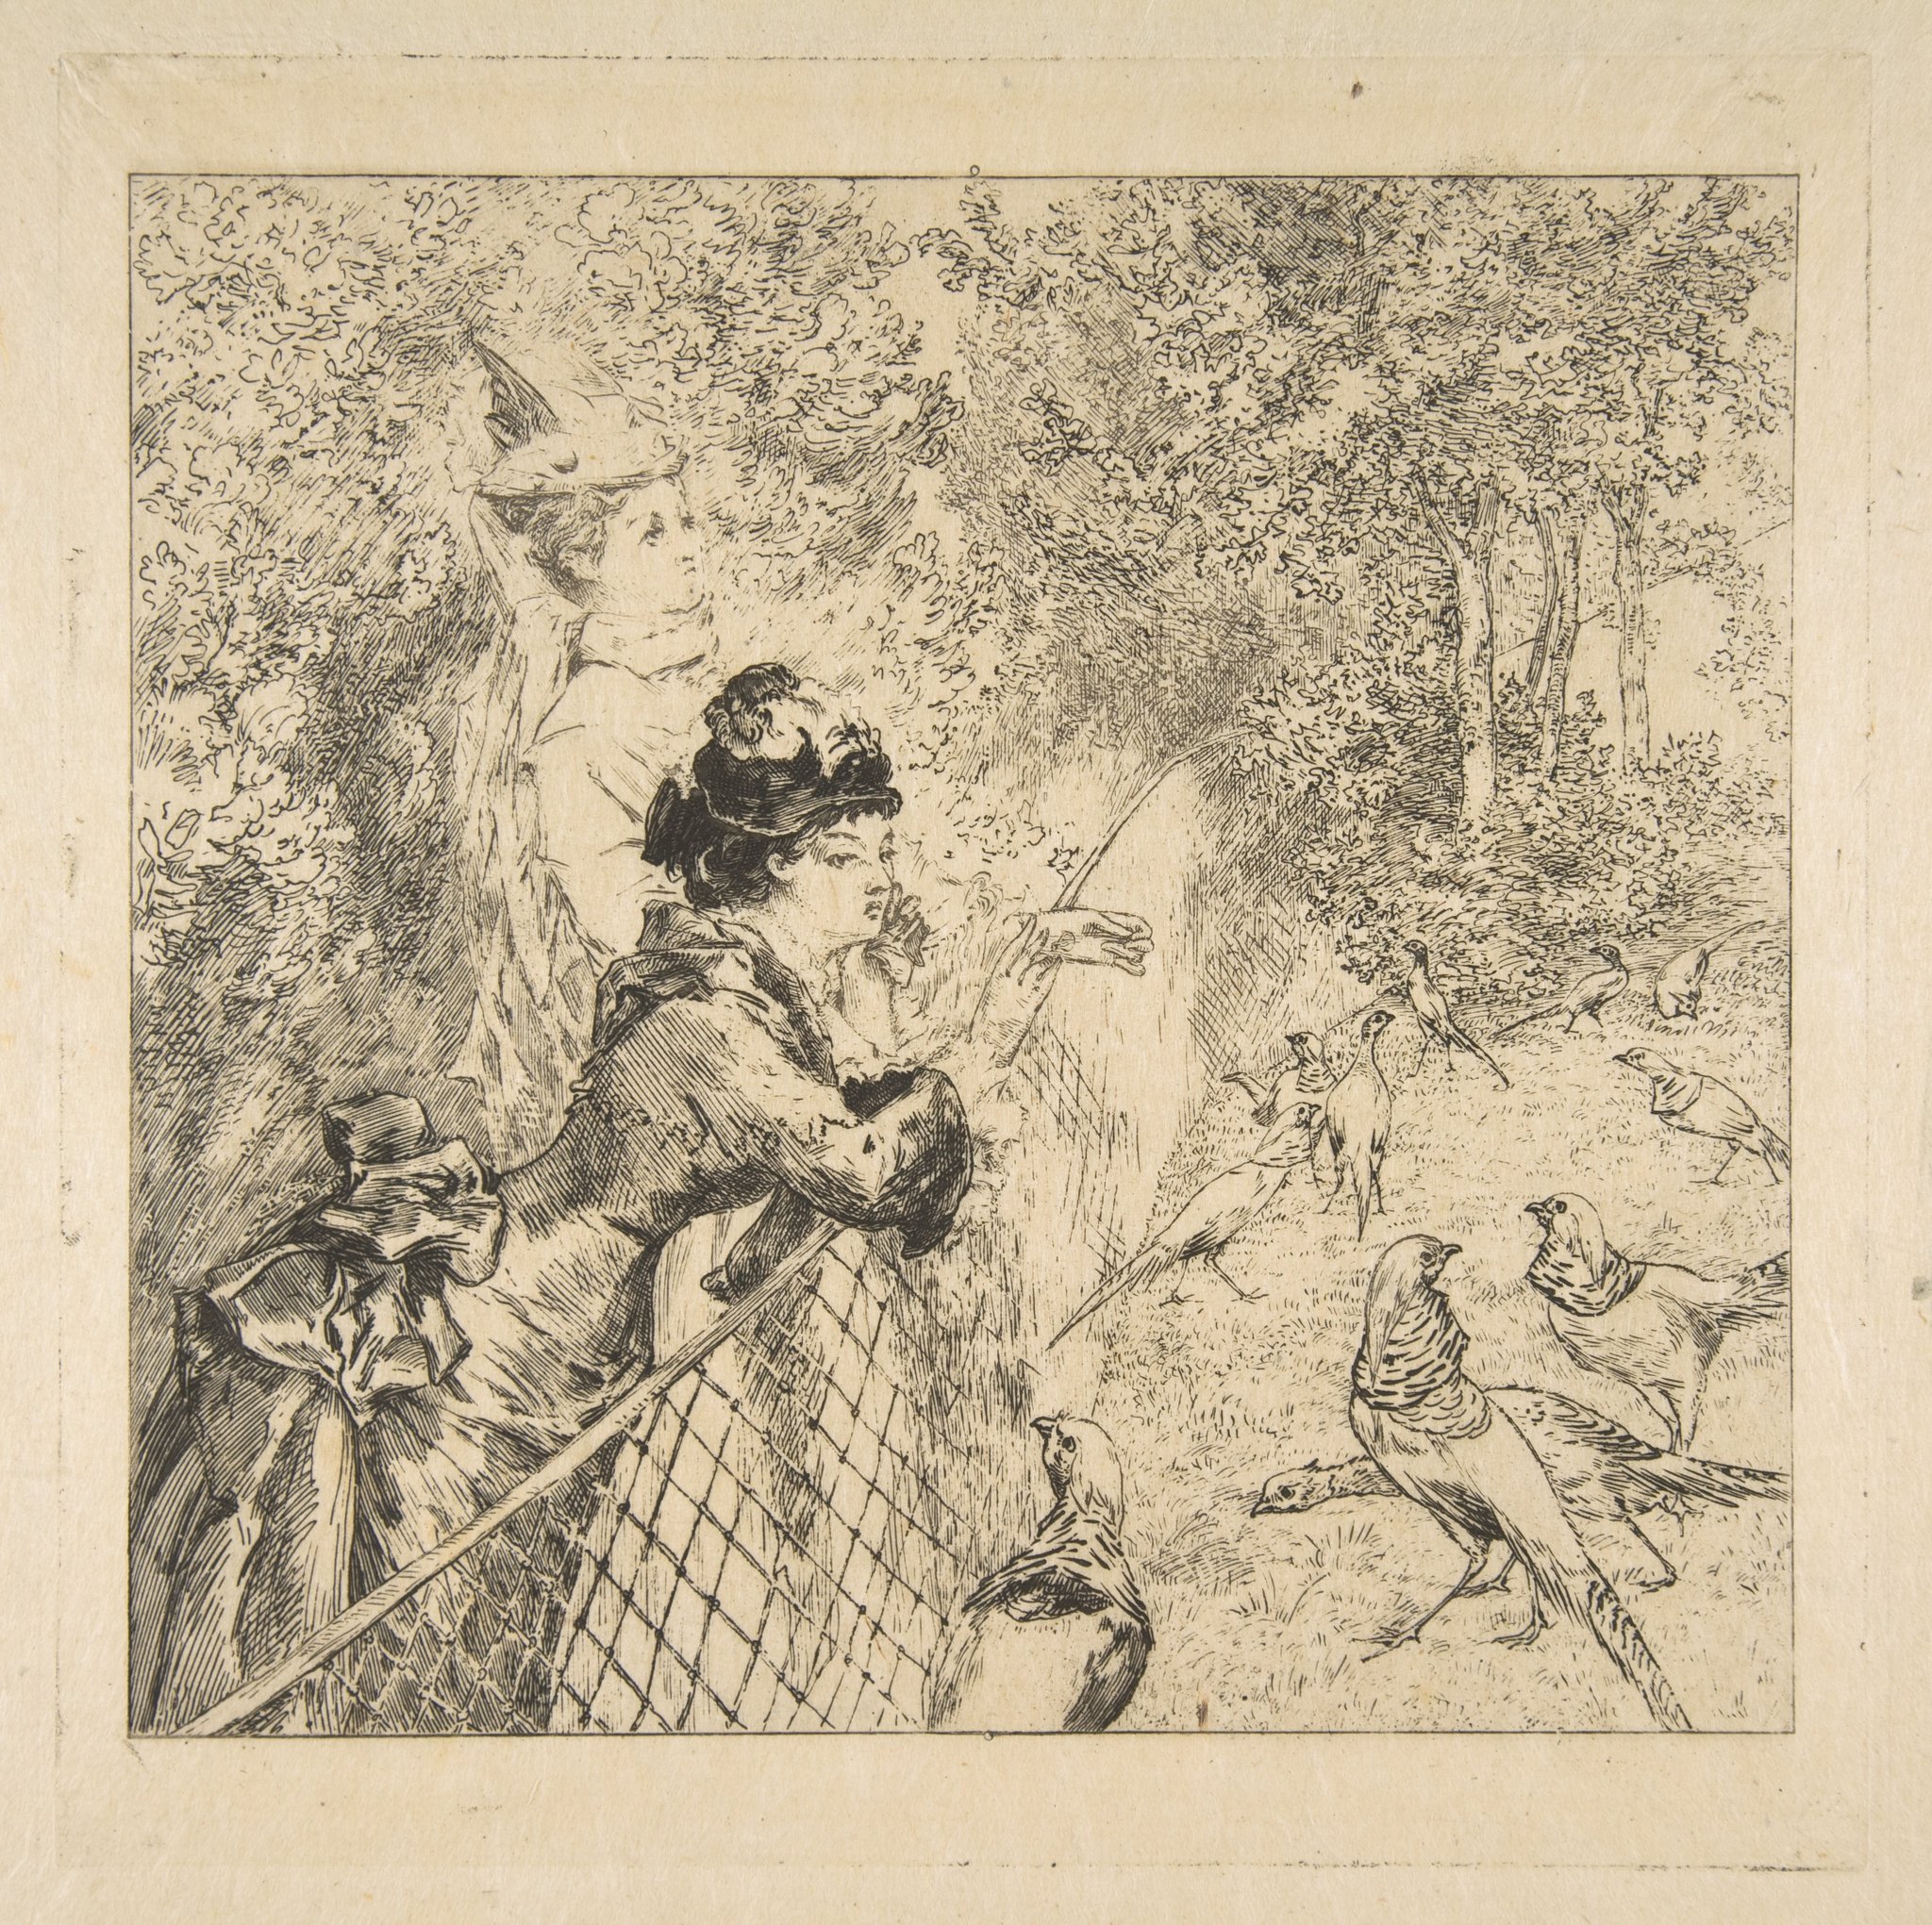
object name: print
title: In the Zoological Garden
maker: félix bracquemond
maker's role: artist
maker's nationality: french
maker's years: 1833-1914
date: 1873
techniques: etching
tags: birds,gardens,women